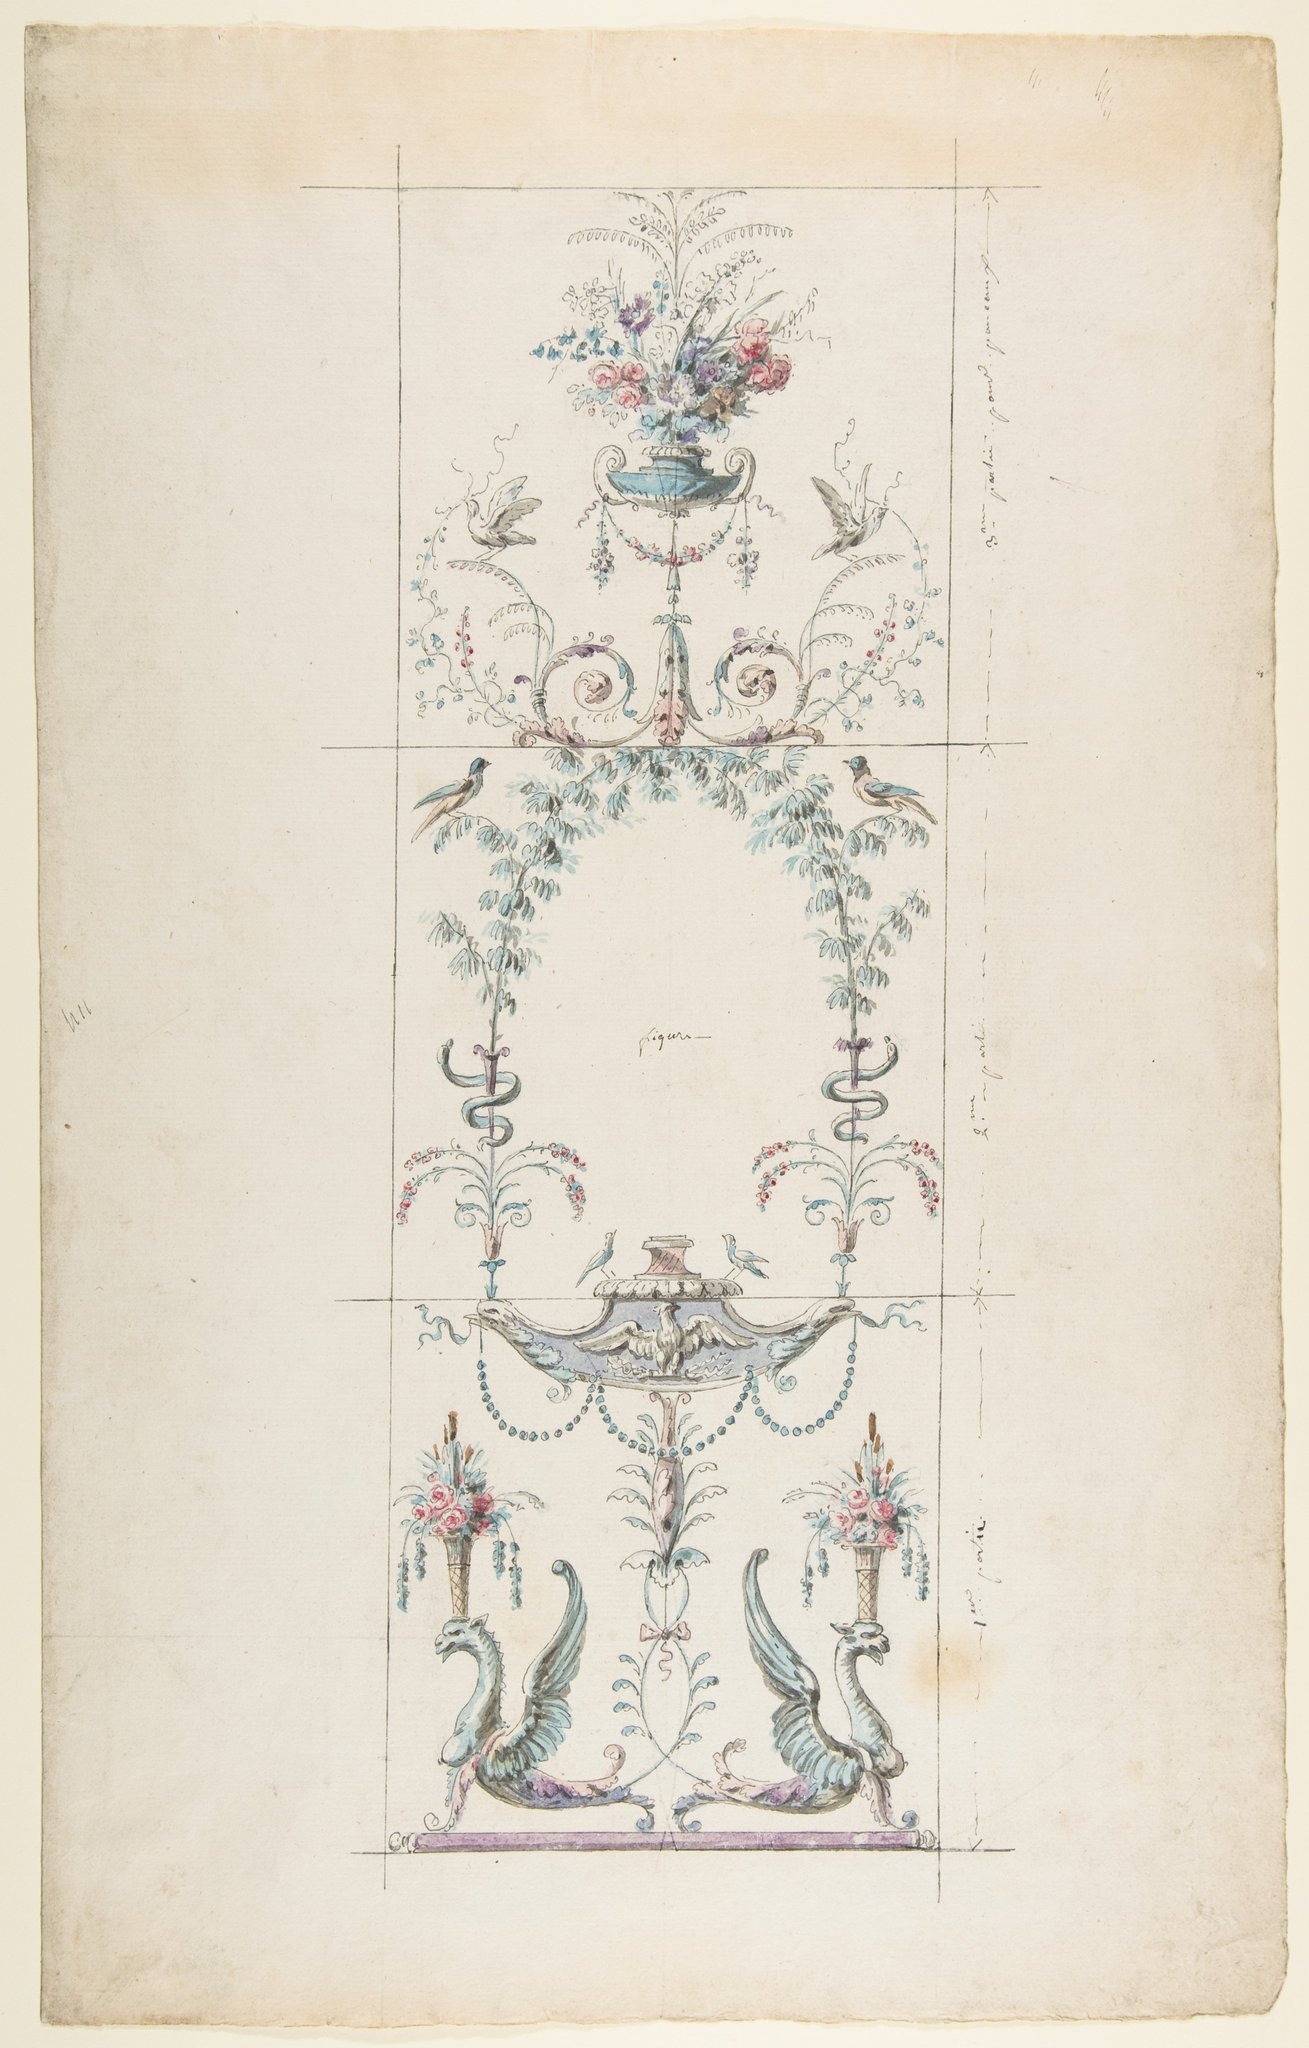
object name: drawing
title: Design for a Wall Panel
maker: henri sallembier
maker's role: artist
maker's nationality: french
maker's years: 1753-1820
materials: ink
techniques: brush, pen, wash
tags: birds,flowers